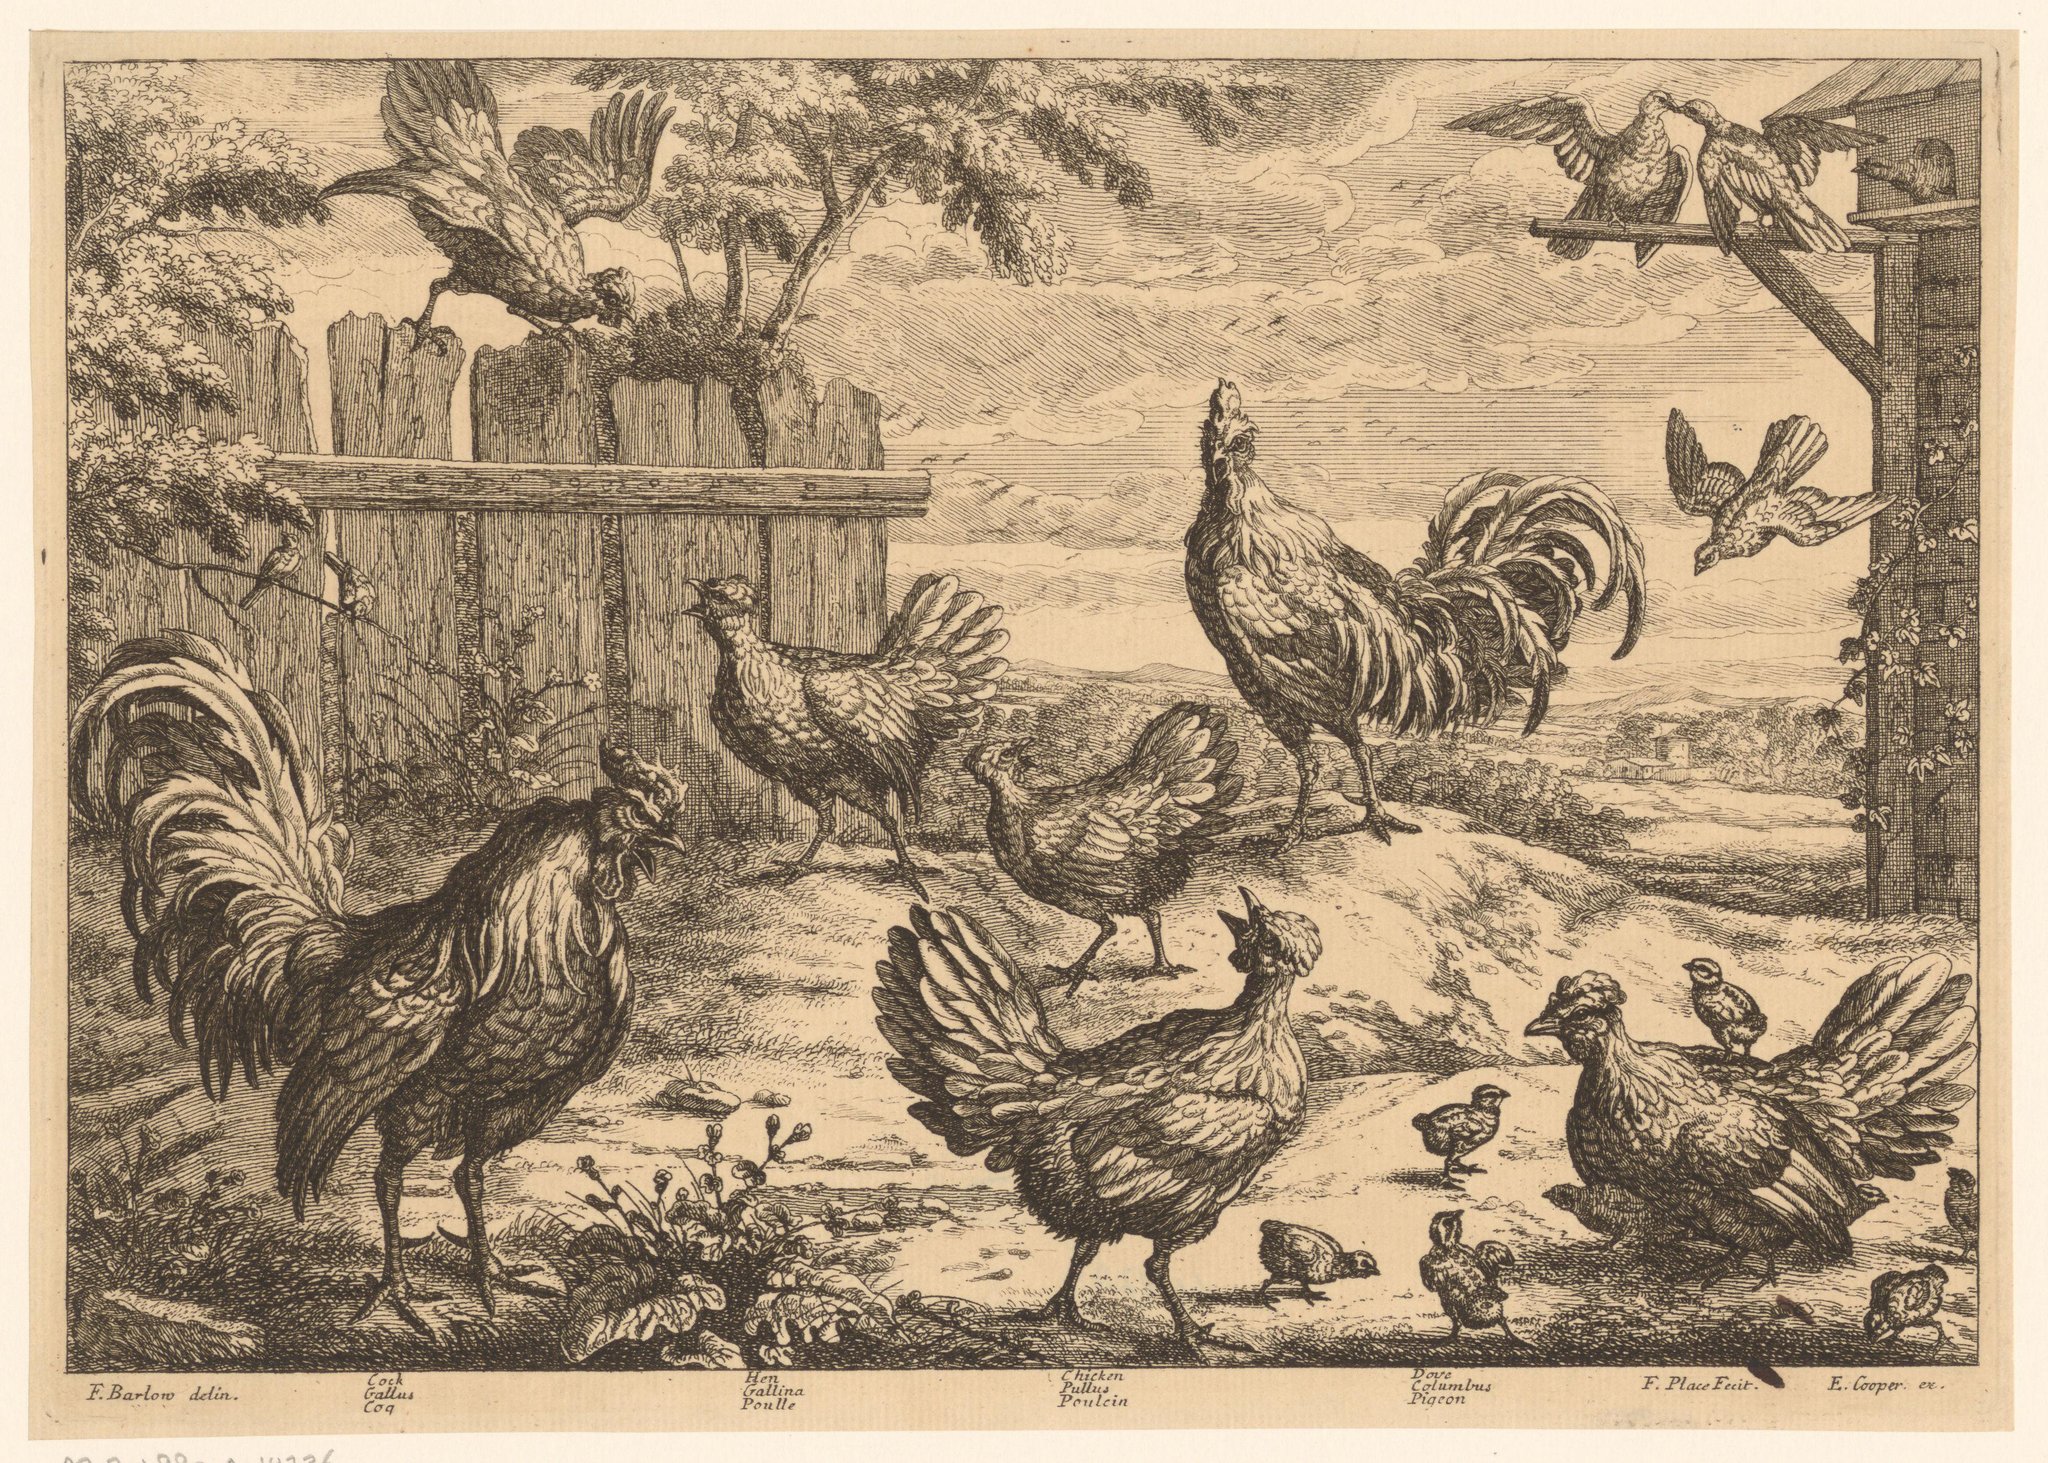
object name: print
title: Voorstellingen van vogels opgedragen aan John Maitland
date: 1686-1723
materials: paper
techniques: etching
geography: great britain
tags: fowl (cock, hen, chicken, etc.), doves, pigeons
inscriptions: collector's mark: Lugt 2228